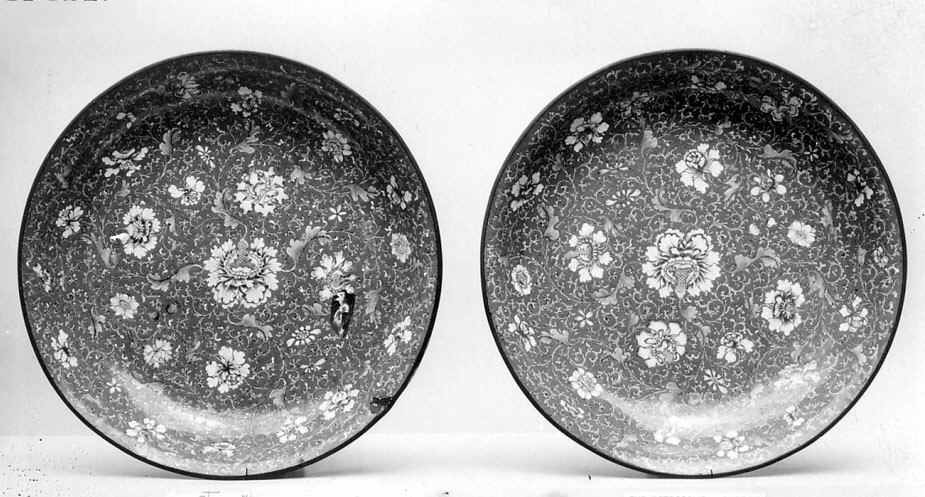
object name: dish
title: Dish (one of a pair)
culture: chinese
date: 1736-1795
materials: enamel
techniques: painting